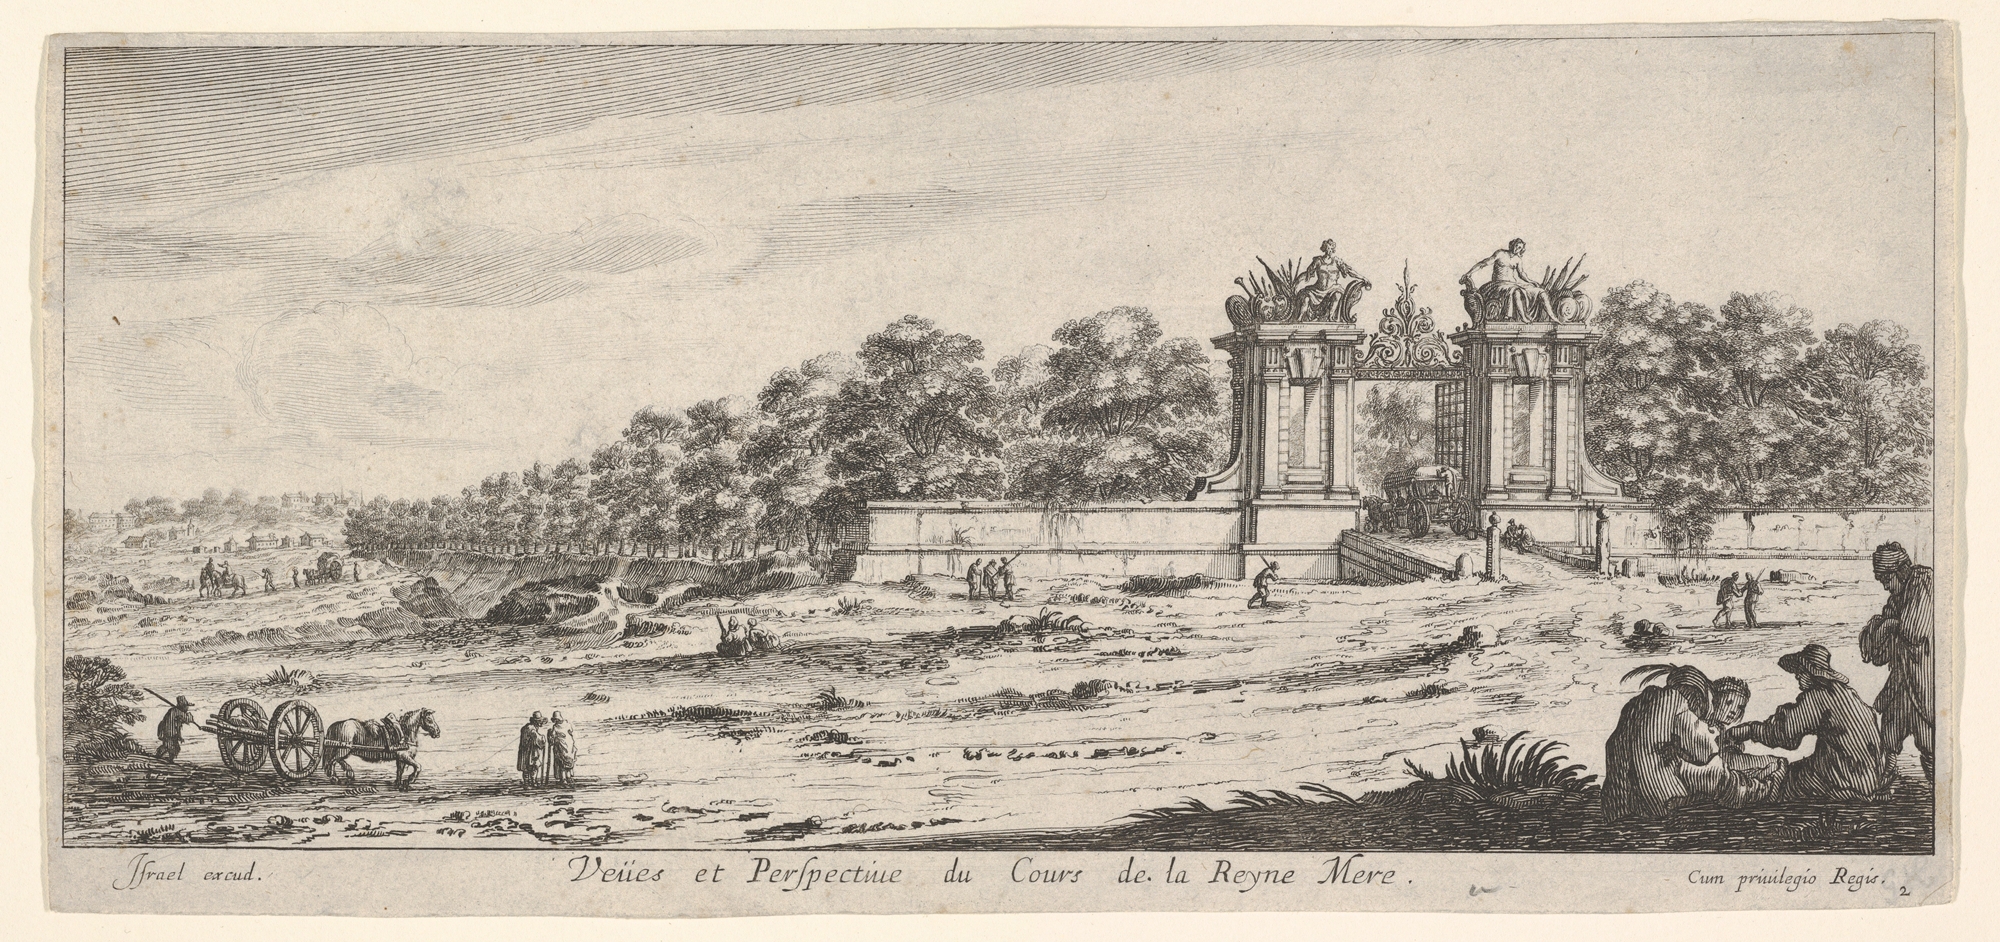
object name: print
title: View of the gate of the residence of the Queen Mother, from "Views and new perspectives, drawn from the most beautiful places of Paris and environs" (Veües et perspectives nouvelles, tirées sur les plus beaux lieux de Paris et des environs)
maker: claude goyrand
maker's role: artist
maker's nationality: french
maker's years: 1620-1662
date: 1644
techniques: etching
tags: gates,men,carriages